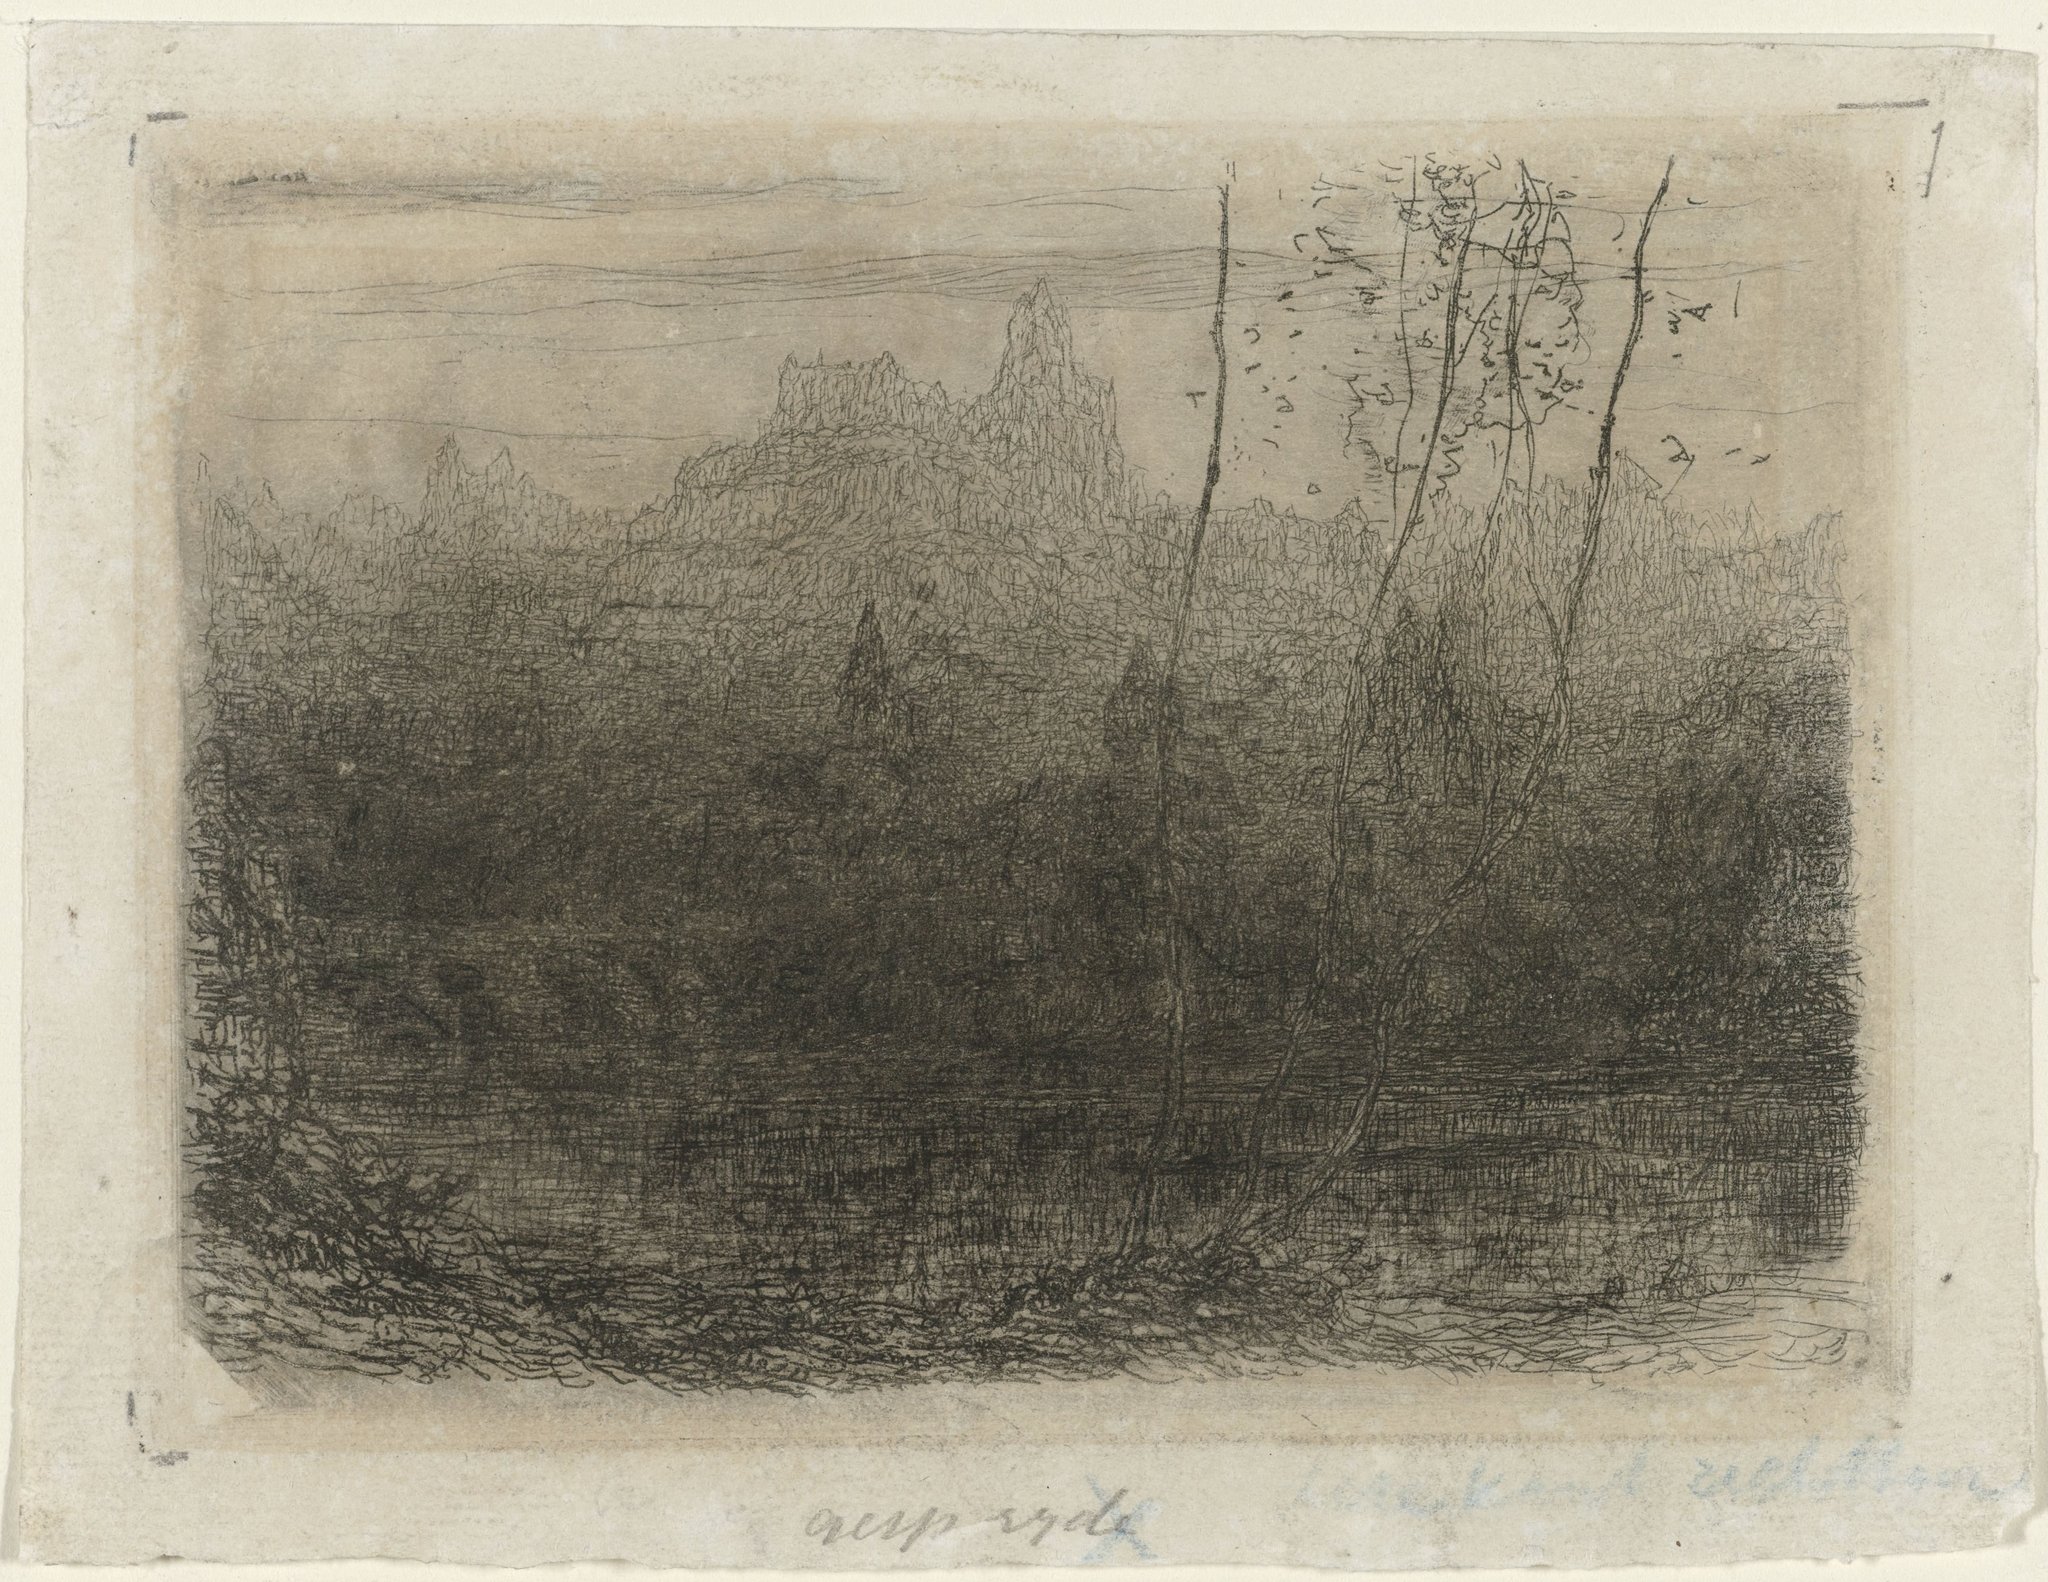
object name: print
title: Betoverde kasteel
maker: matthijs maris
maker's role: draughtsman, painter, print maker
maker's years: 1839-1917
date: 1887-1888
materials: paper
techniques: etching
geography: london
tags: trees, landscape with ruins